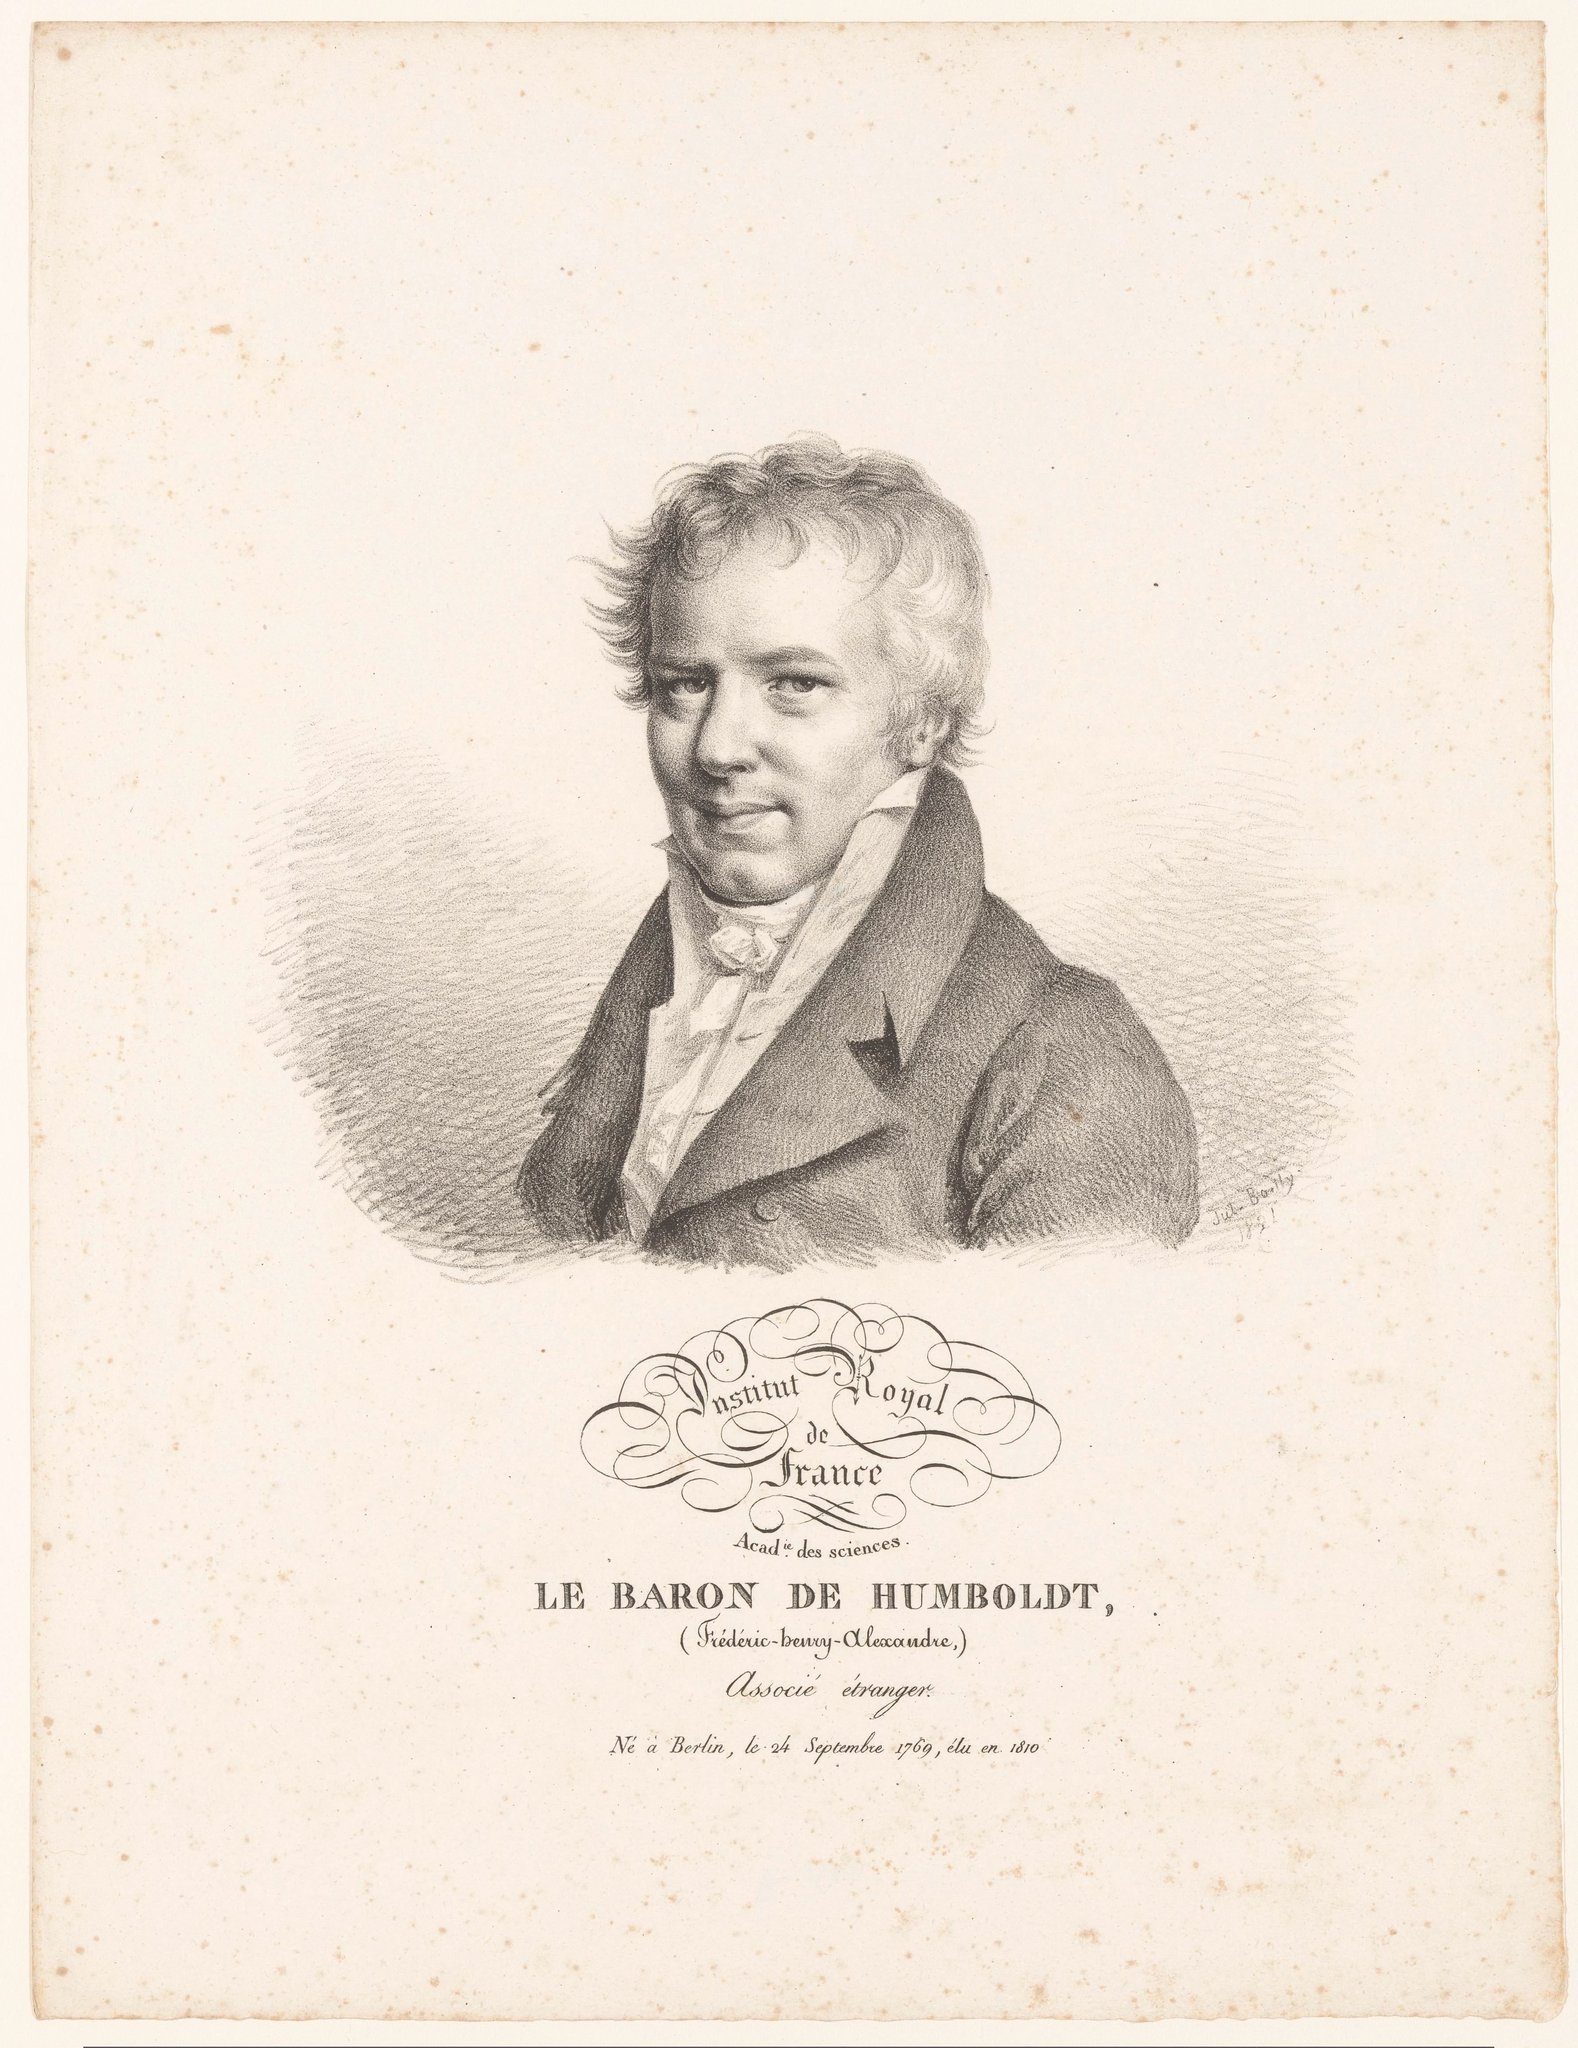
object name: print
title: Leden van het Institut Royal de France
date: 1821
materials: paper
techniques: lithograph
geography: paris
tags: berlin, historical persons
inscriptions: collector's mark: Lugt 2228a